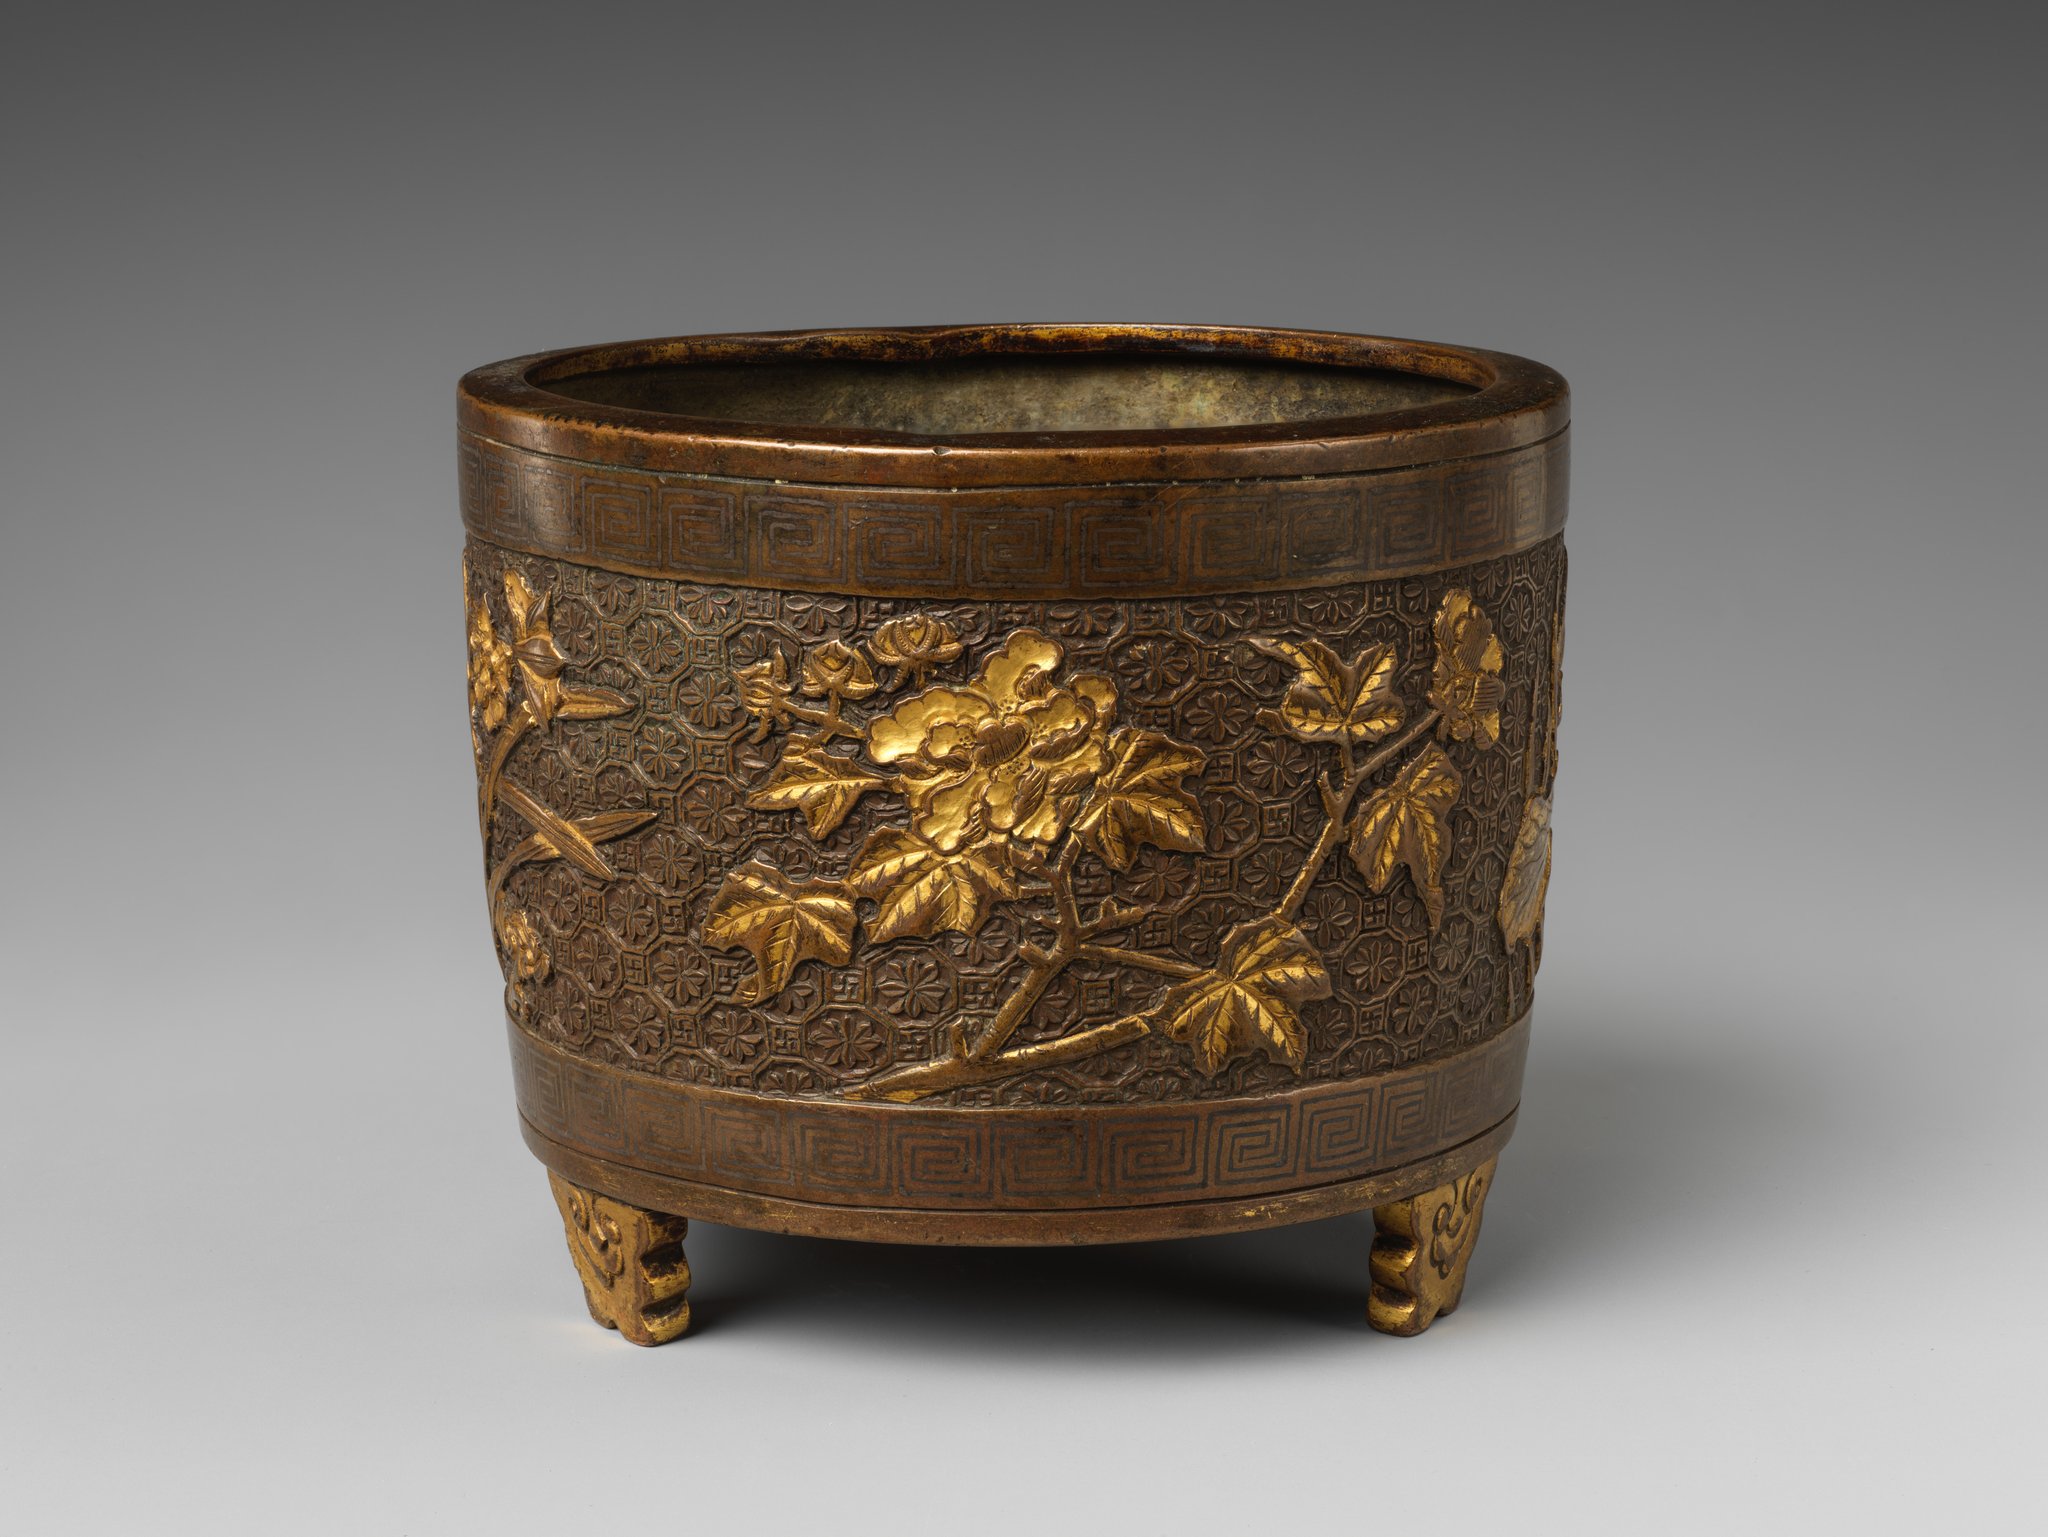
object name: incense burner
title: Incense burner with flowers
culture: chinese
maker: hu wenming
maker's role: artist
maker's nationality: chinese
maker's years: 1550-1650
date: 1501-1700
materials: copper alloy, silver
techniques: gilding, inlay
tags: peonies